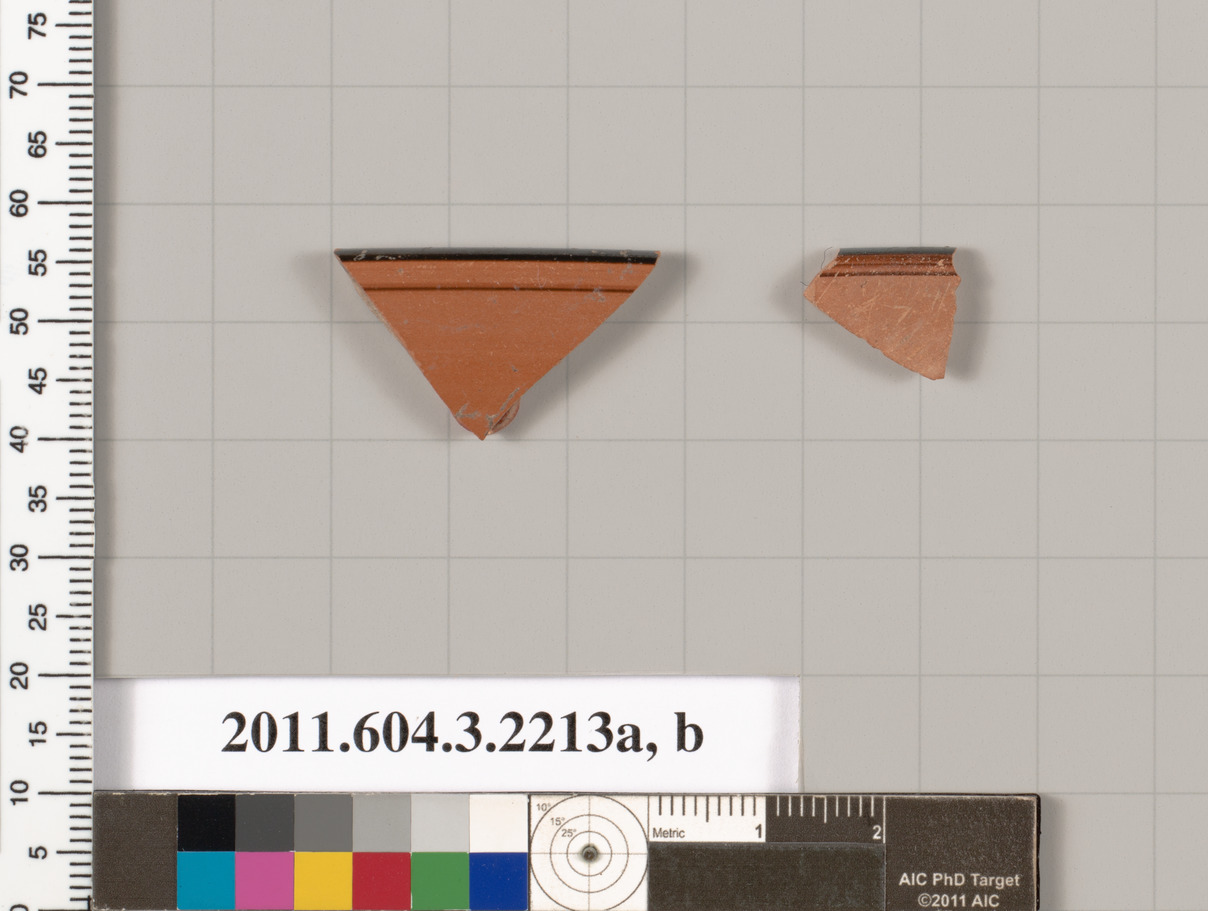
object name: kylix fragment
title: Terracotta rim fragments of kylikes (drinking cups)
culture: greek, attic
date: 600-401 BCE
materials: terracotta